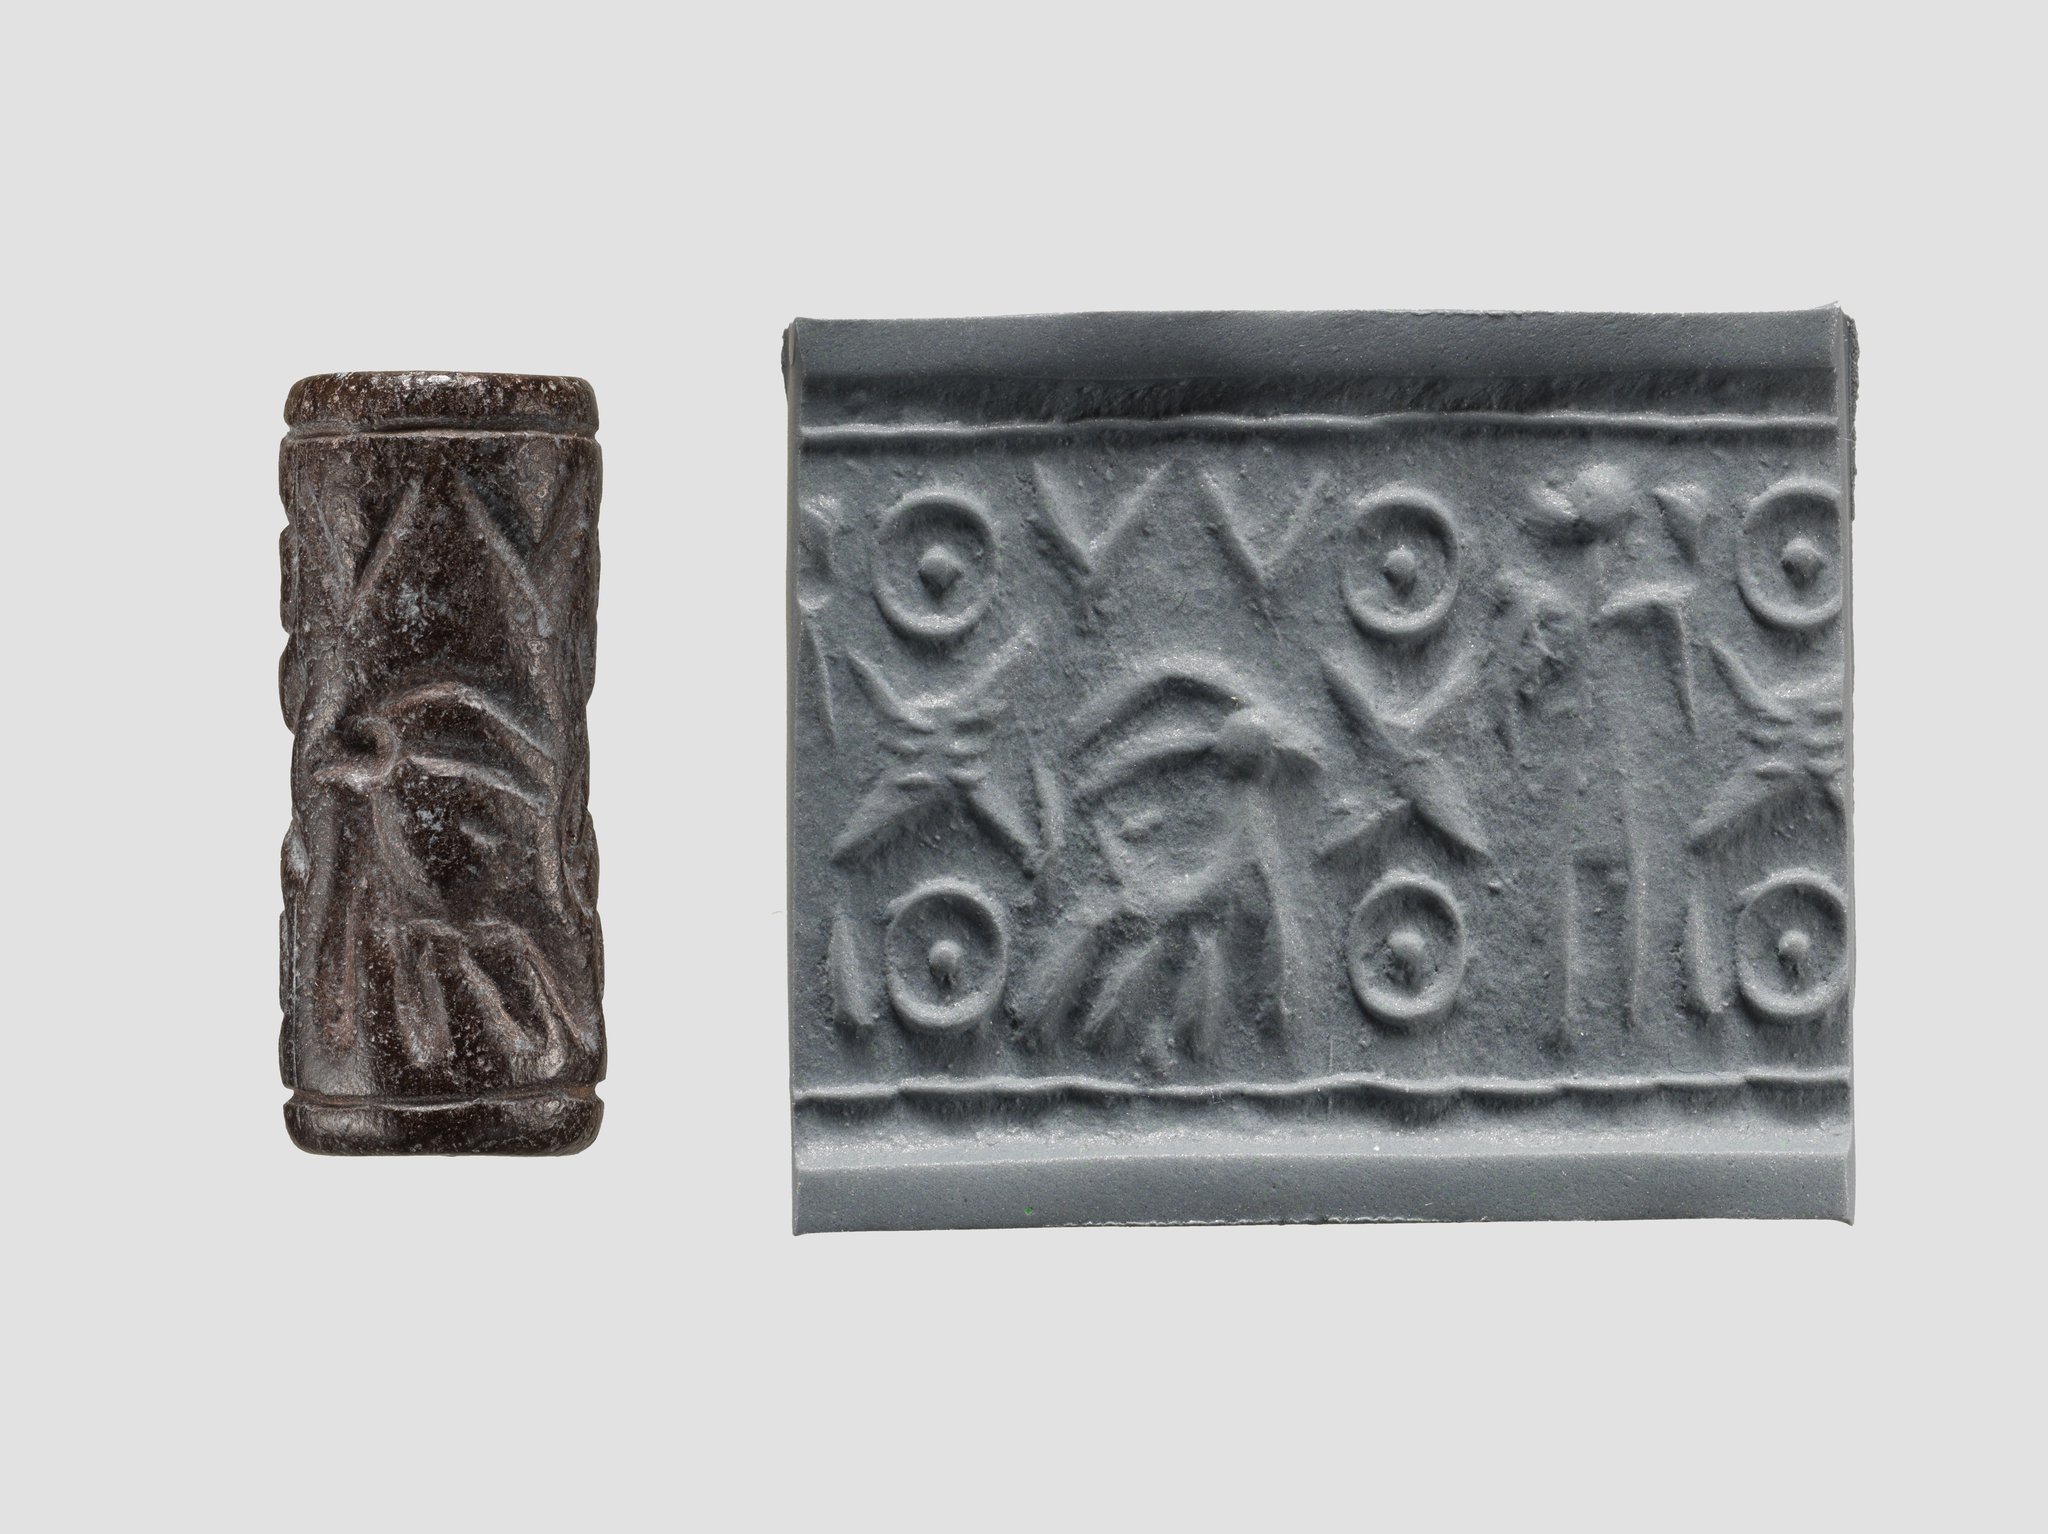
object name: cylinder seal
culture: cypriot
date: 1500-1201 BCE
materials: stone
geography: cyprus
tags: animals